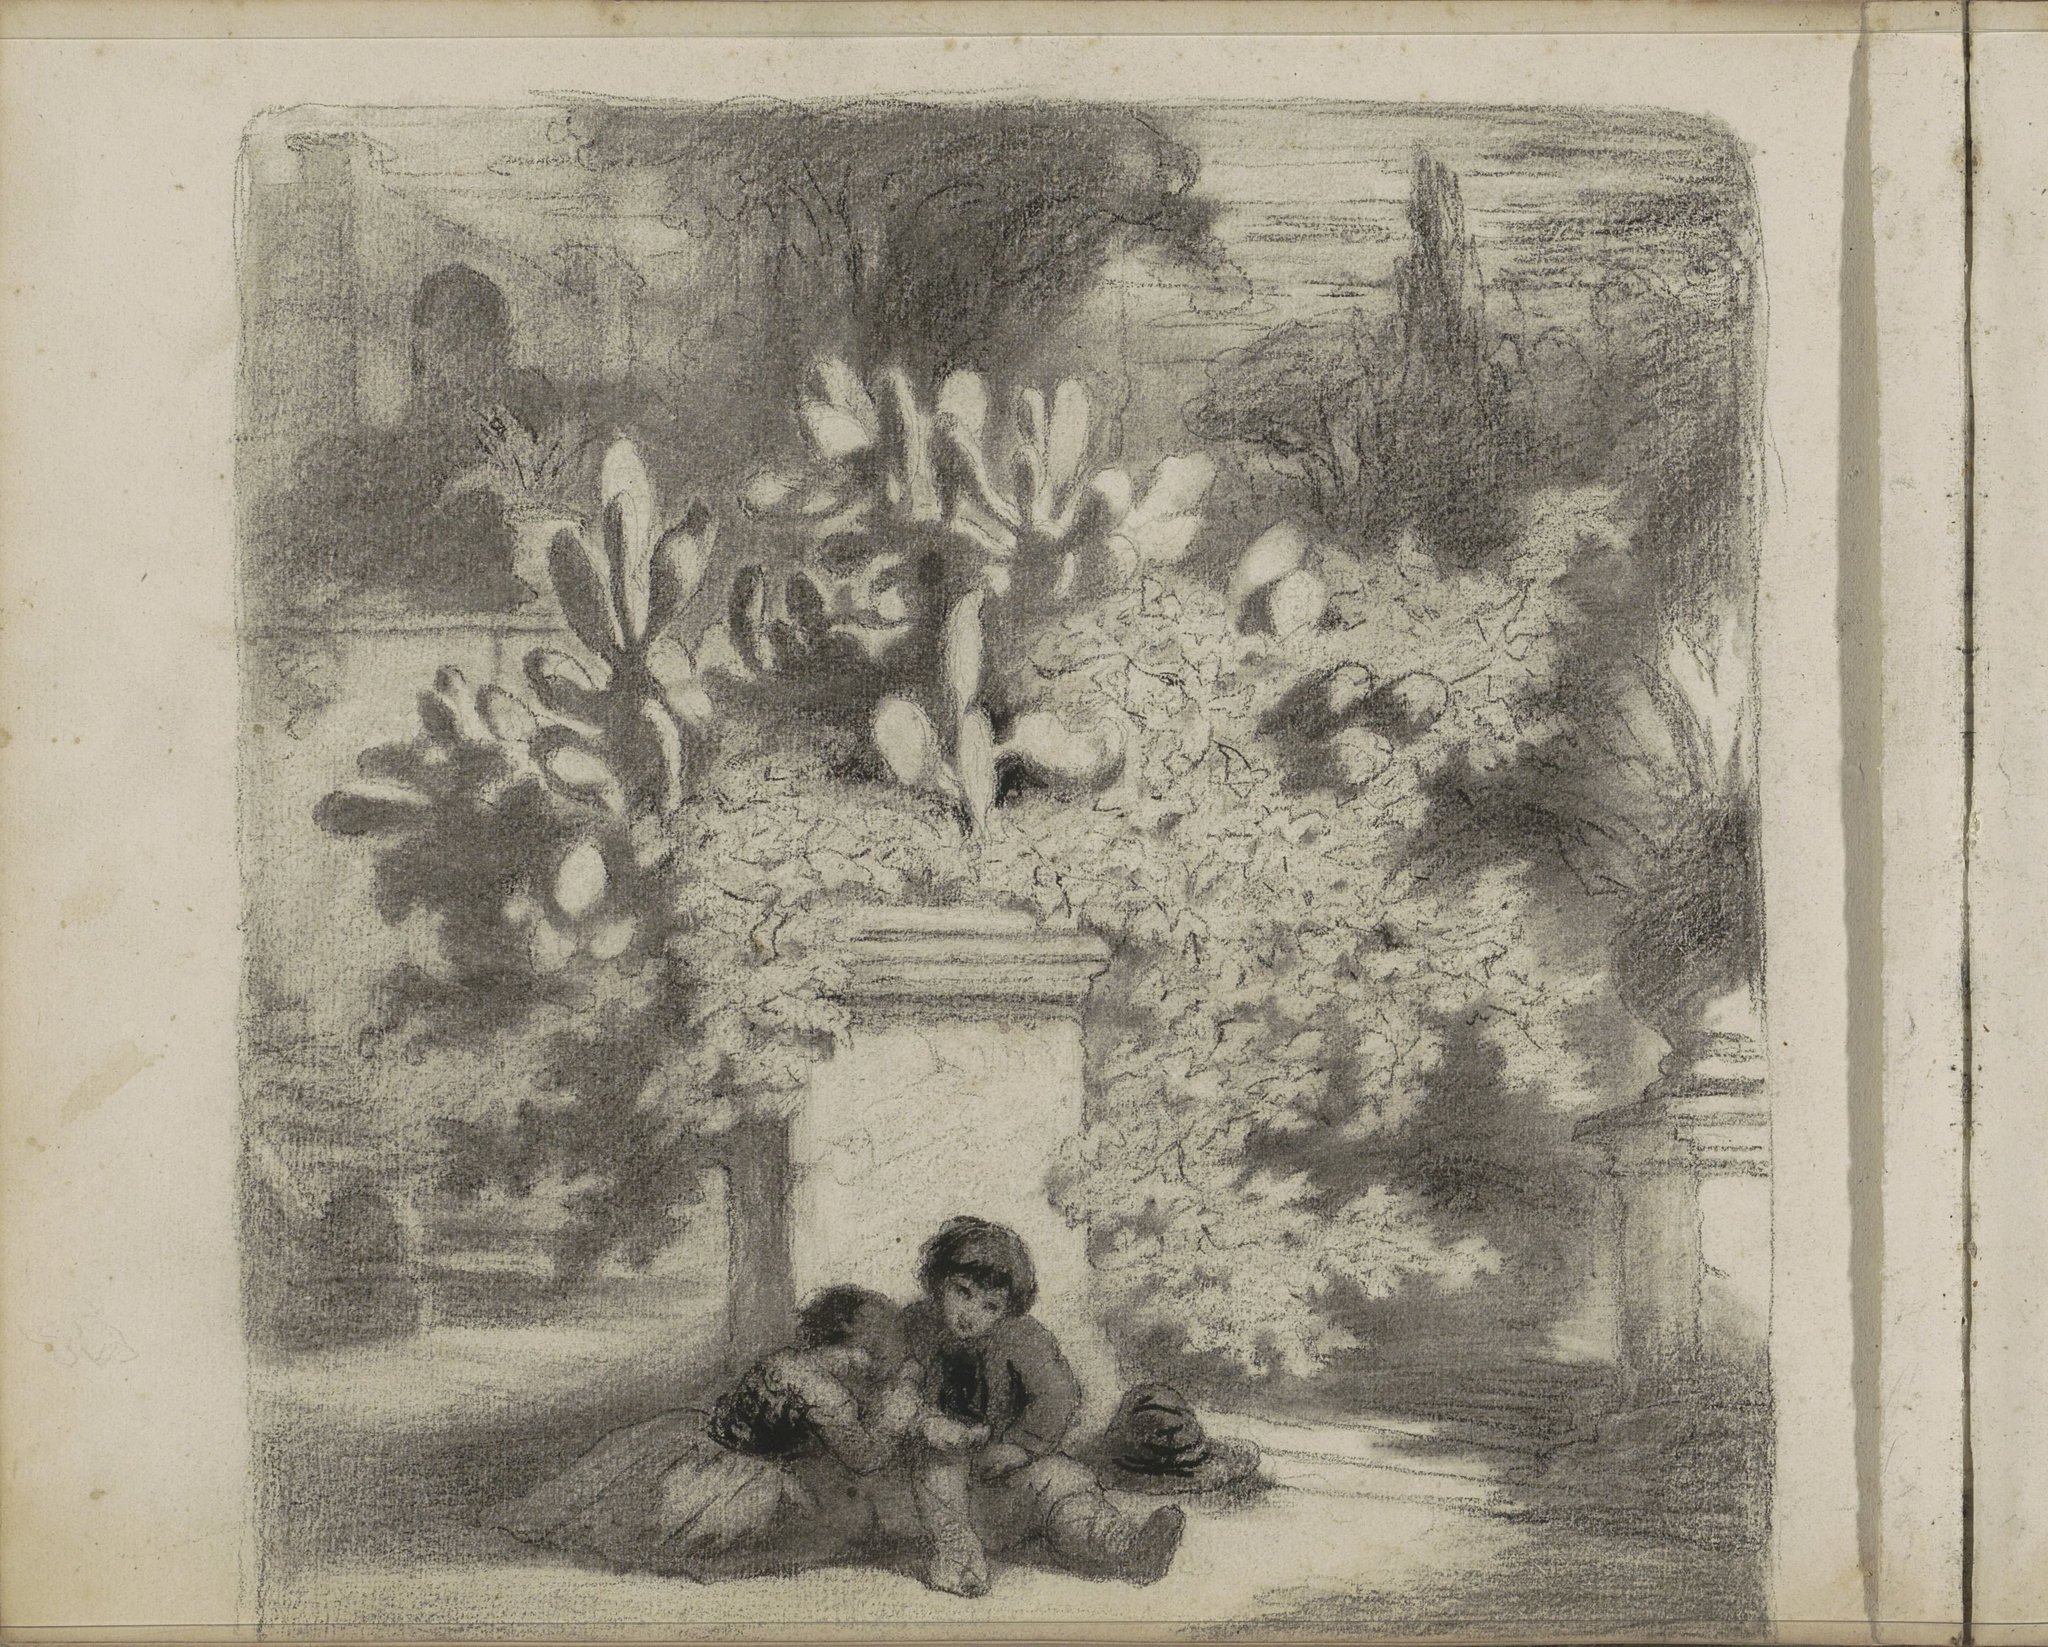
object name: sketchbook leaf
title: Twee kinderen in een tuin of park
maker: gerrit postma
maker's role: draughtsman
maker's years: 1819-1894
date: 1829-1894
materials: chalk, paper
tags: park, garden, child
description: De twee kinderen zitten bij een stenen sokkel. Tekening in een kader. Blad 30 verso uit een schetsboek met 35 bladen.